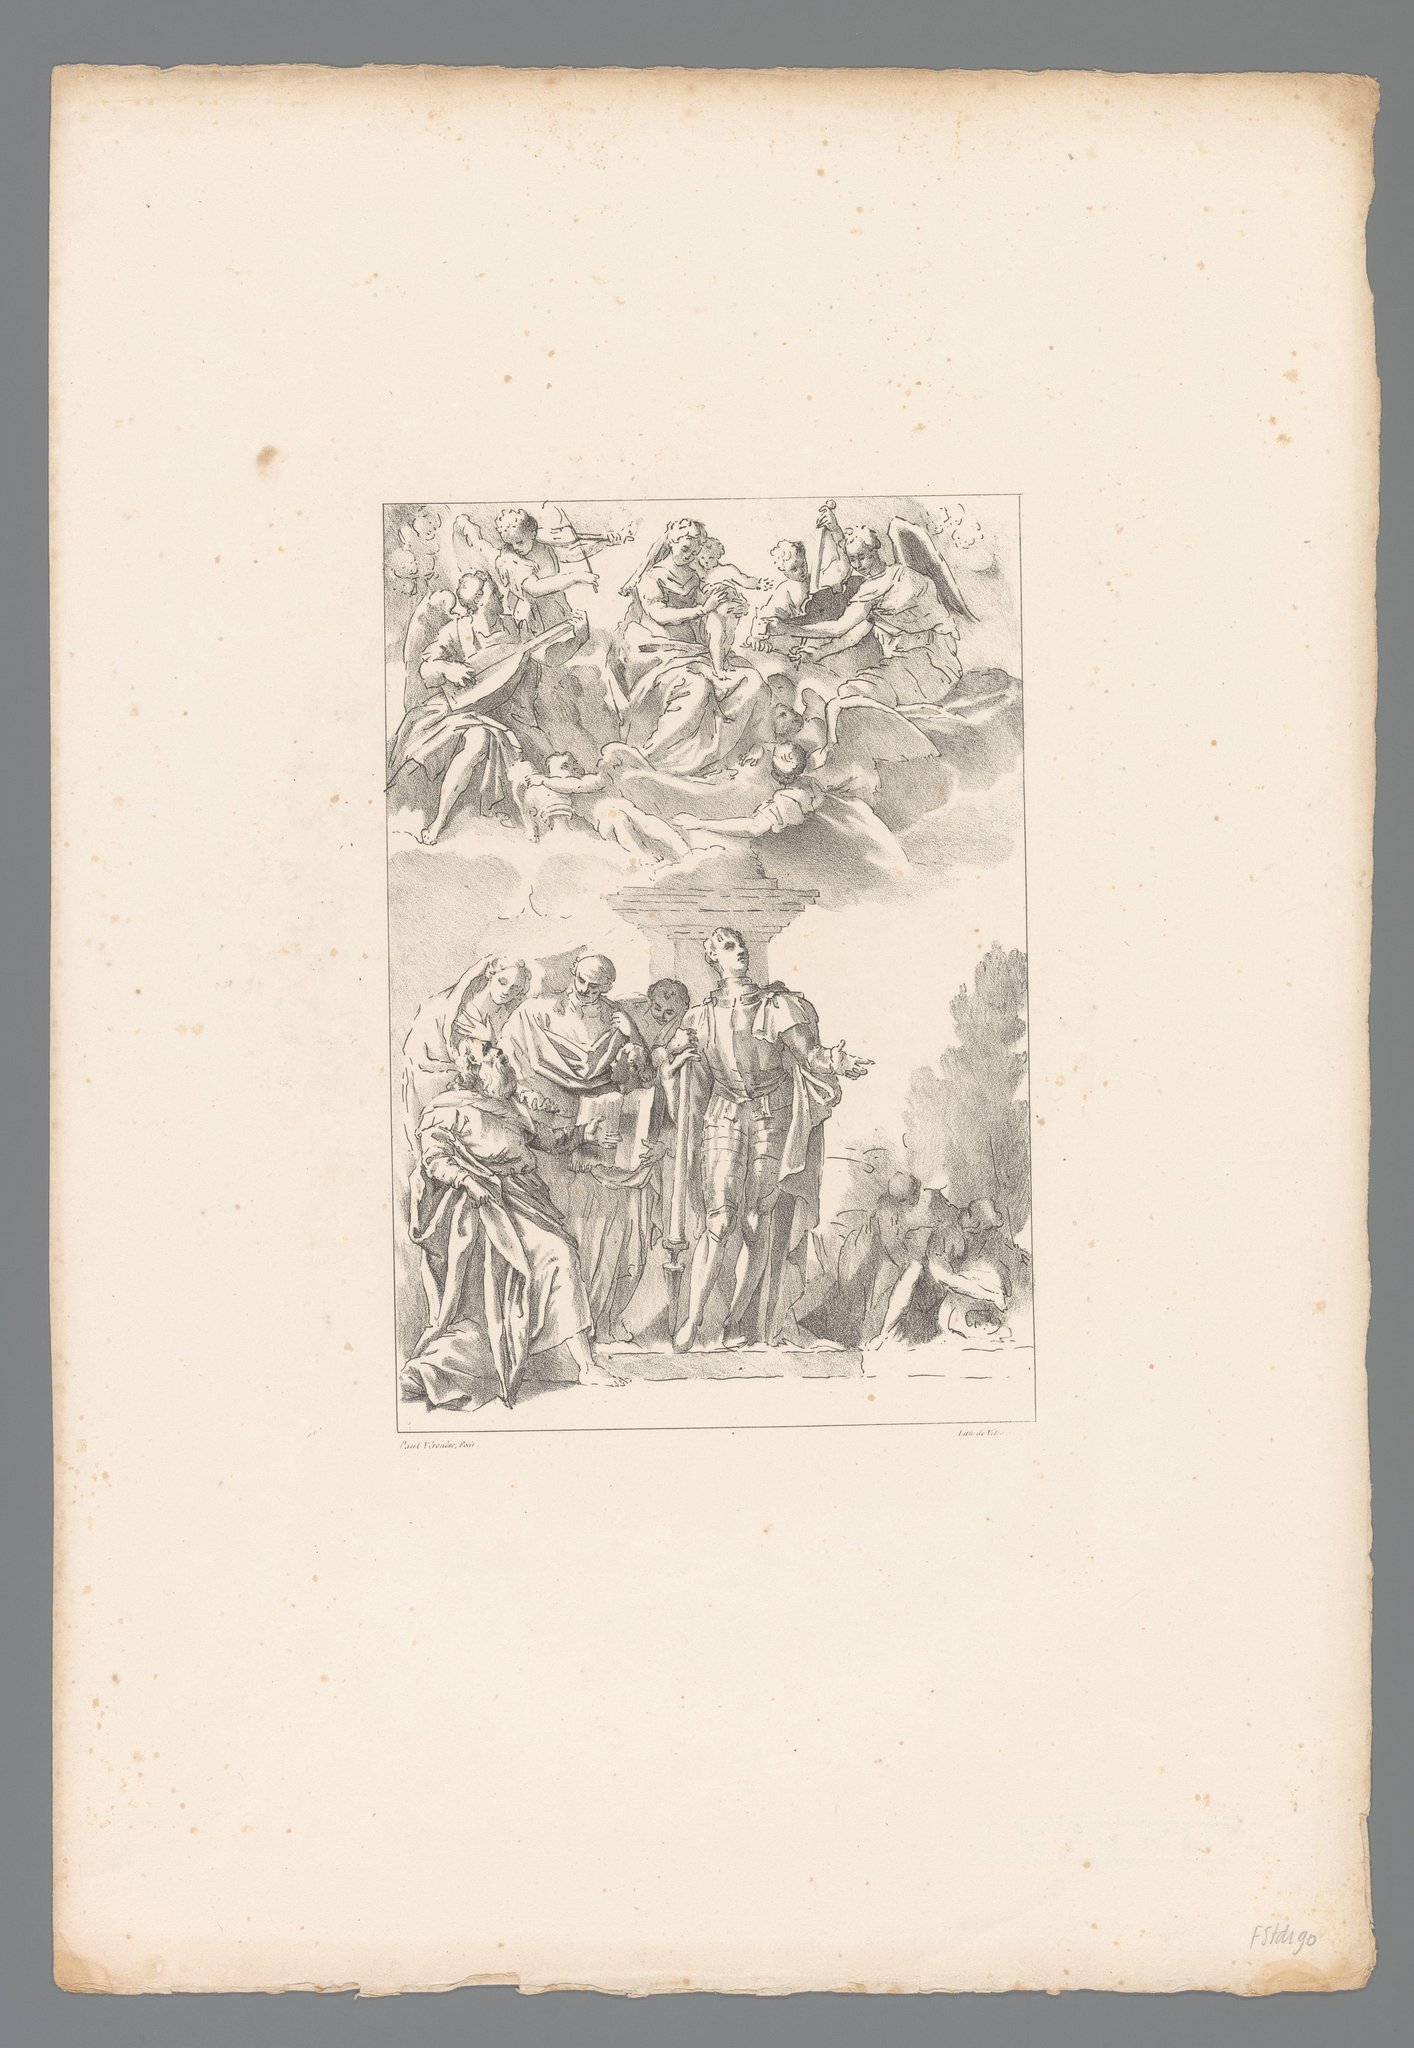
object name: print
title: Maria met Christus en engelen in de hemel wordt aanbeden vanaf de aarde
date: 1822-1834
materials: paper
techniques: lithograph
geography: paris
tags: madonna: i.e. mary with the christ-child (+ angel(s))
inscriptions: inscription: ‘Uit Chabert gal des peintres’, collector's mark: Lugt 2233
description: Prent waarschijnlijk uit: Galerie des peintres, ou collection de portraits des peintres le plus célèbres de toutes les écoles, accompagnée de leur notice historique, de leurs dessins et d'un discours sur les arts. 3 dln. Parijs: Jean-Claude Chabert, 1822-1834.